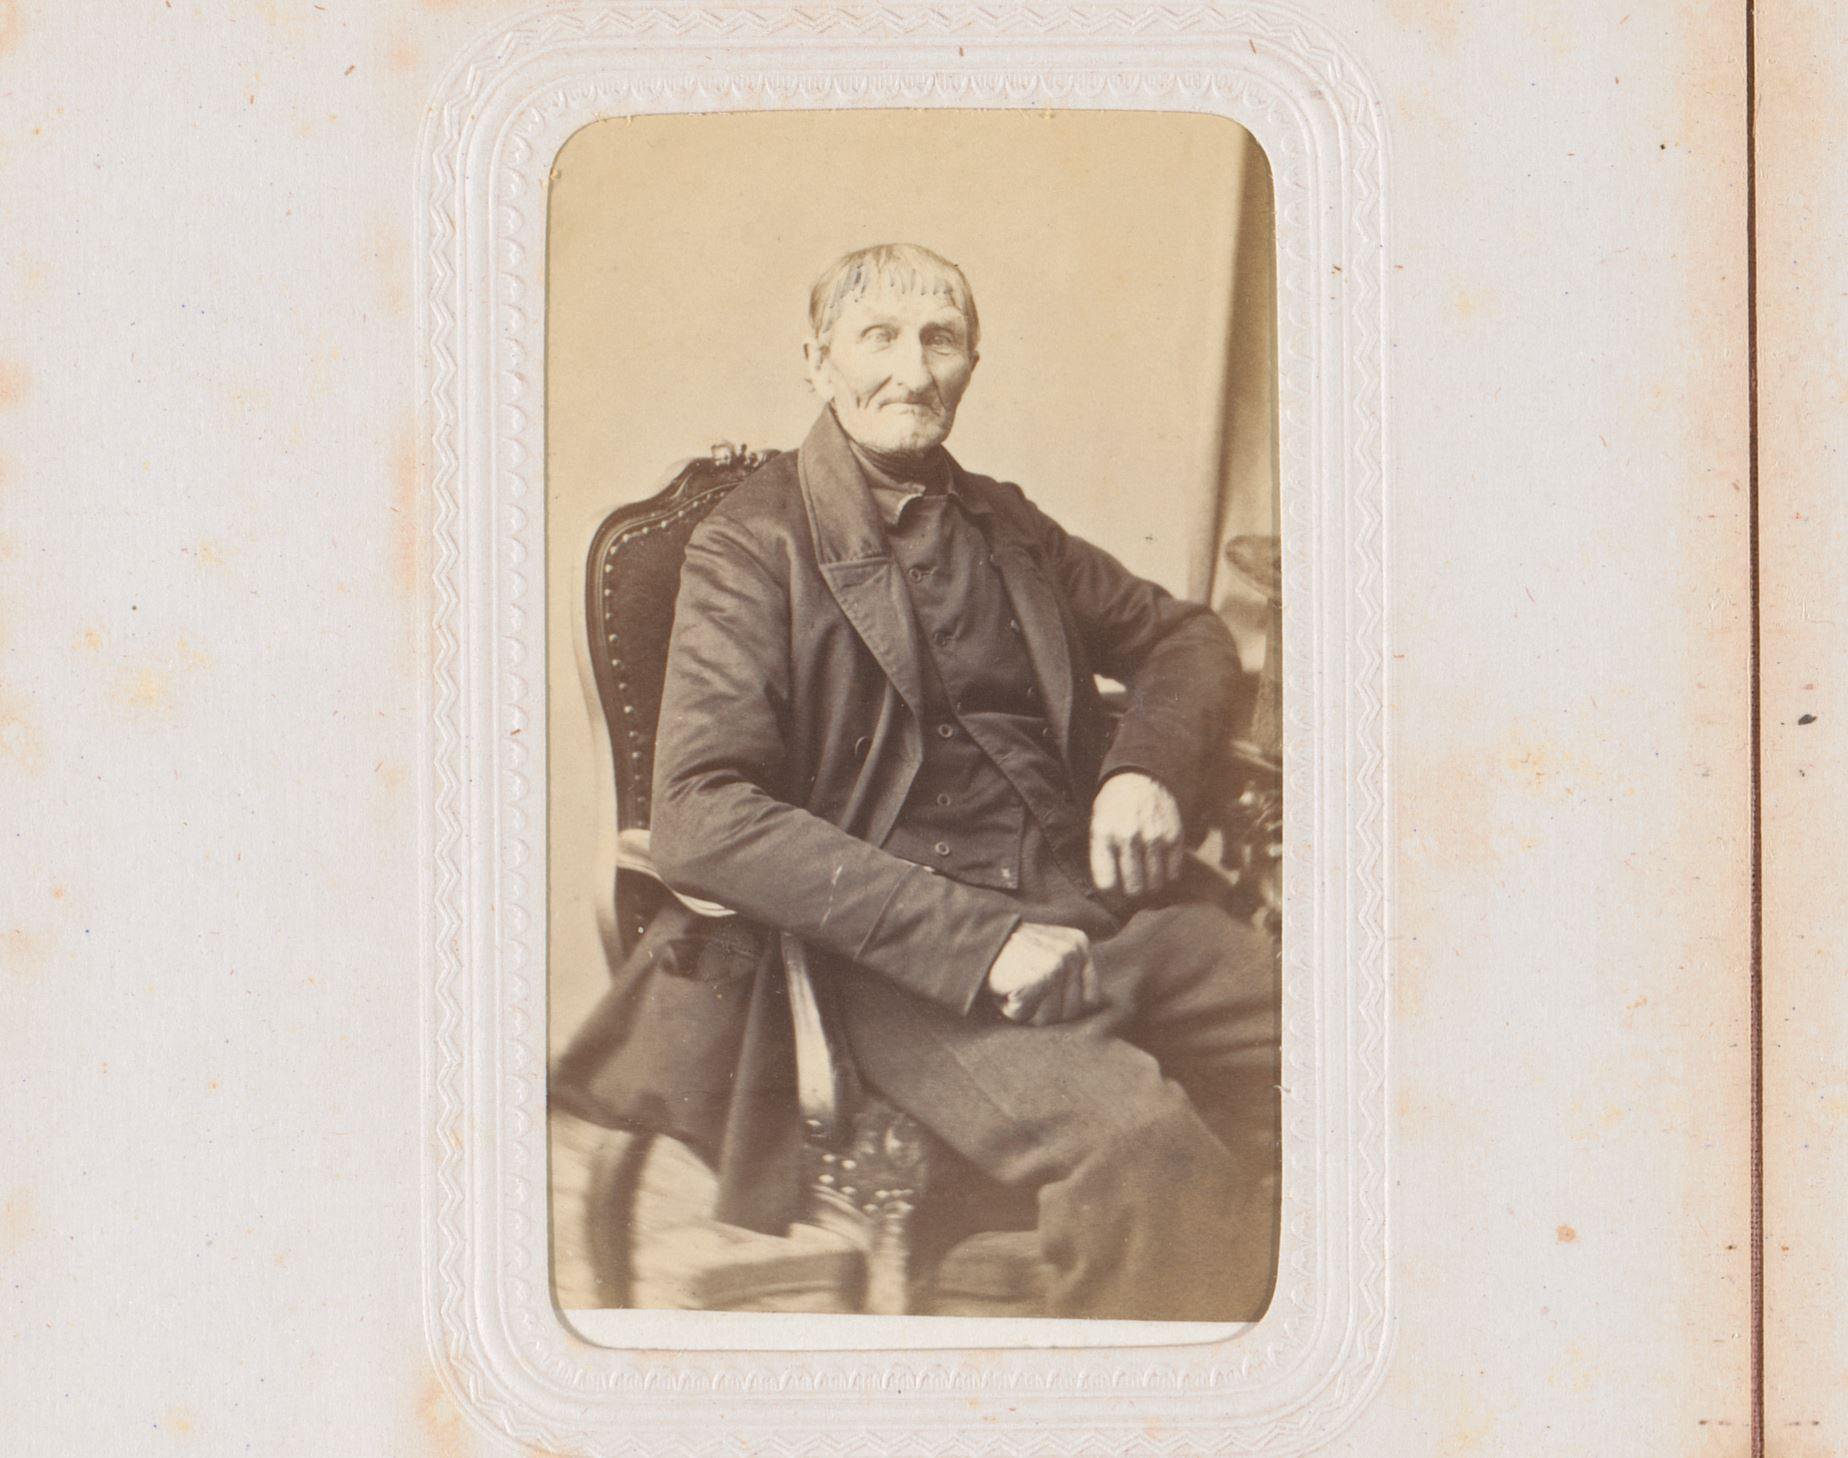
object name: album leaf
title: Portret van een man, zittend aan een tafel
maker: kornelis willem schorteldoek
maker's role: boekbinder, fotograaf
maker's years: 1800-1885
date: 1855-1885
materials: cardboard, photographic support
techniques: albumen print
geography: gorinchem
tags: sitting figure, historical persons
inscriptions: inscription: ‘SCHORTELDOEK/ PHOTOGRAAF/ GORINCHEM/ Groote Markt’